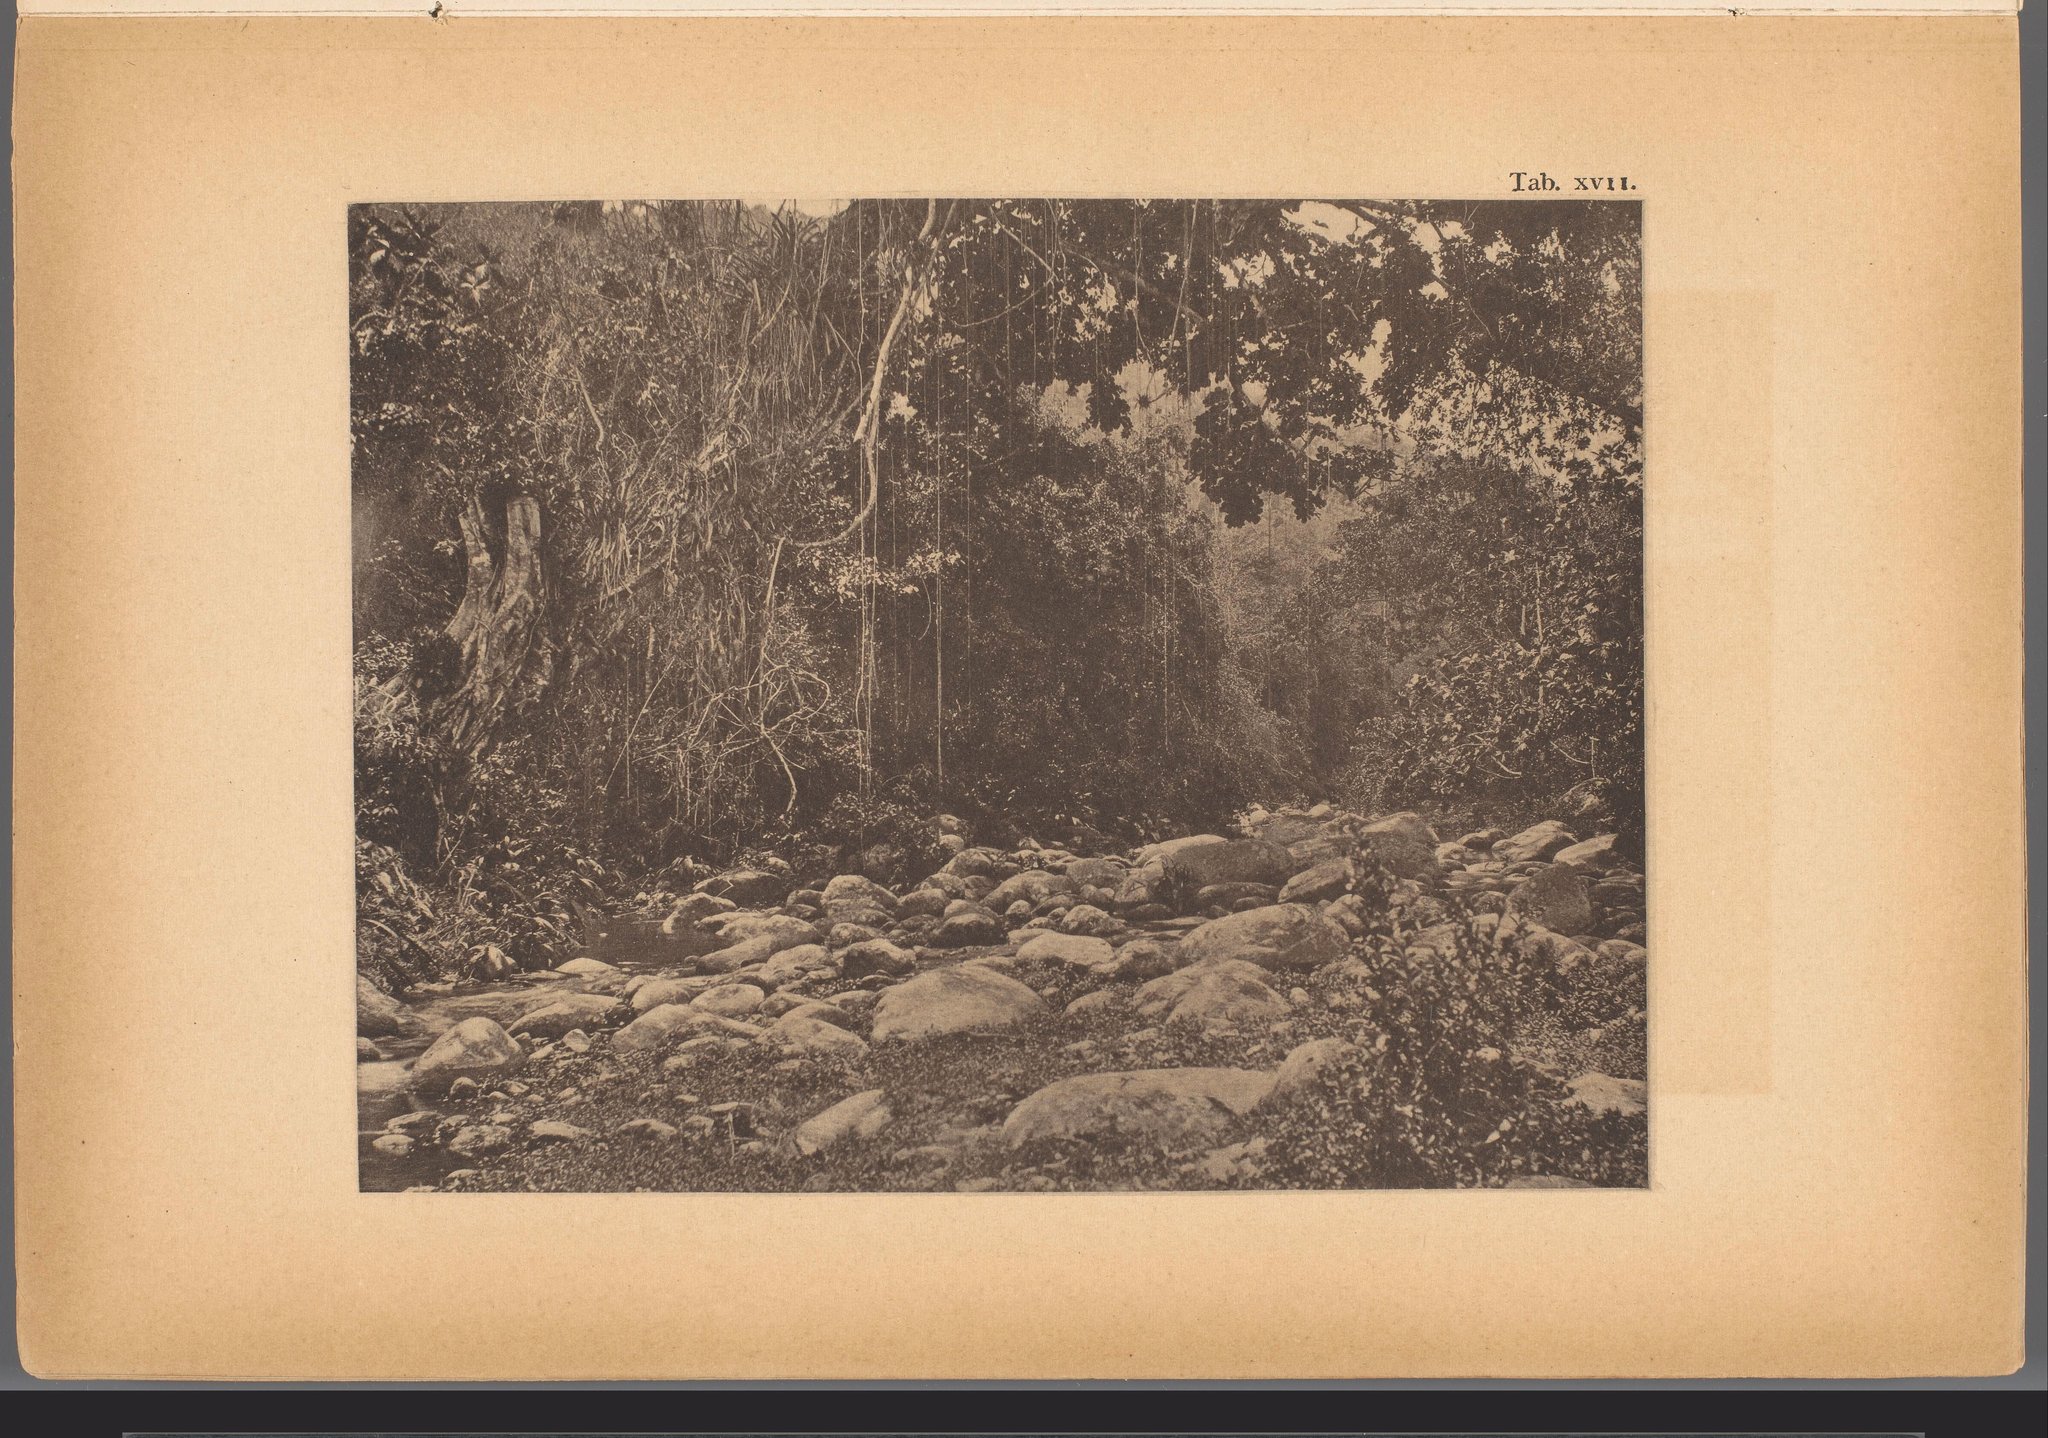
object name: page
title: Gezicht op een bedding van de rivier San Esteban in Venezuela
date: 1877-1887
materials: paper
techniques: photograph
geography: venezuela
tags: forest, wood, dry river, river bed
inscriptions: number: ‘Tab. XVII.’